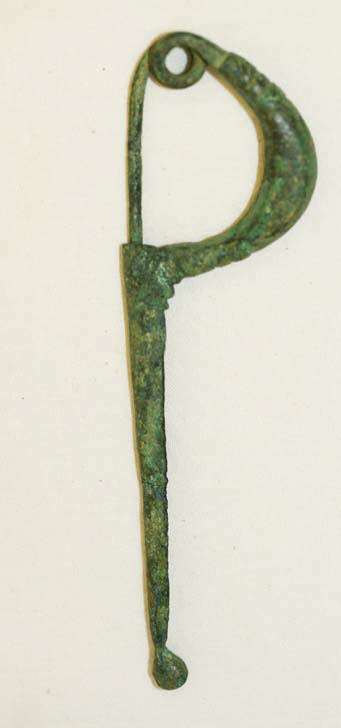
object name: pin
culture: european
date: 400-301 BCE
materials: bronze